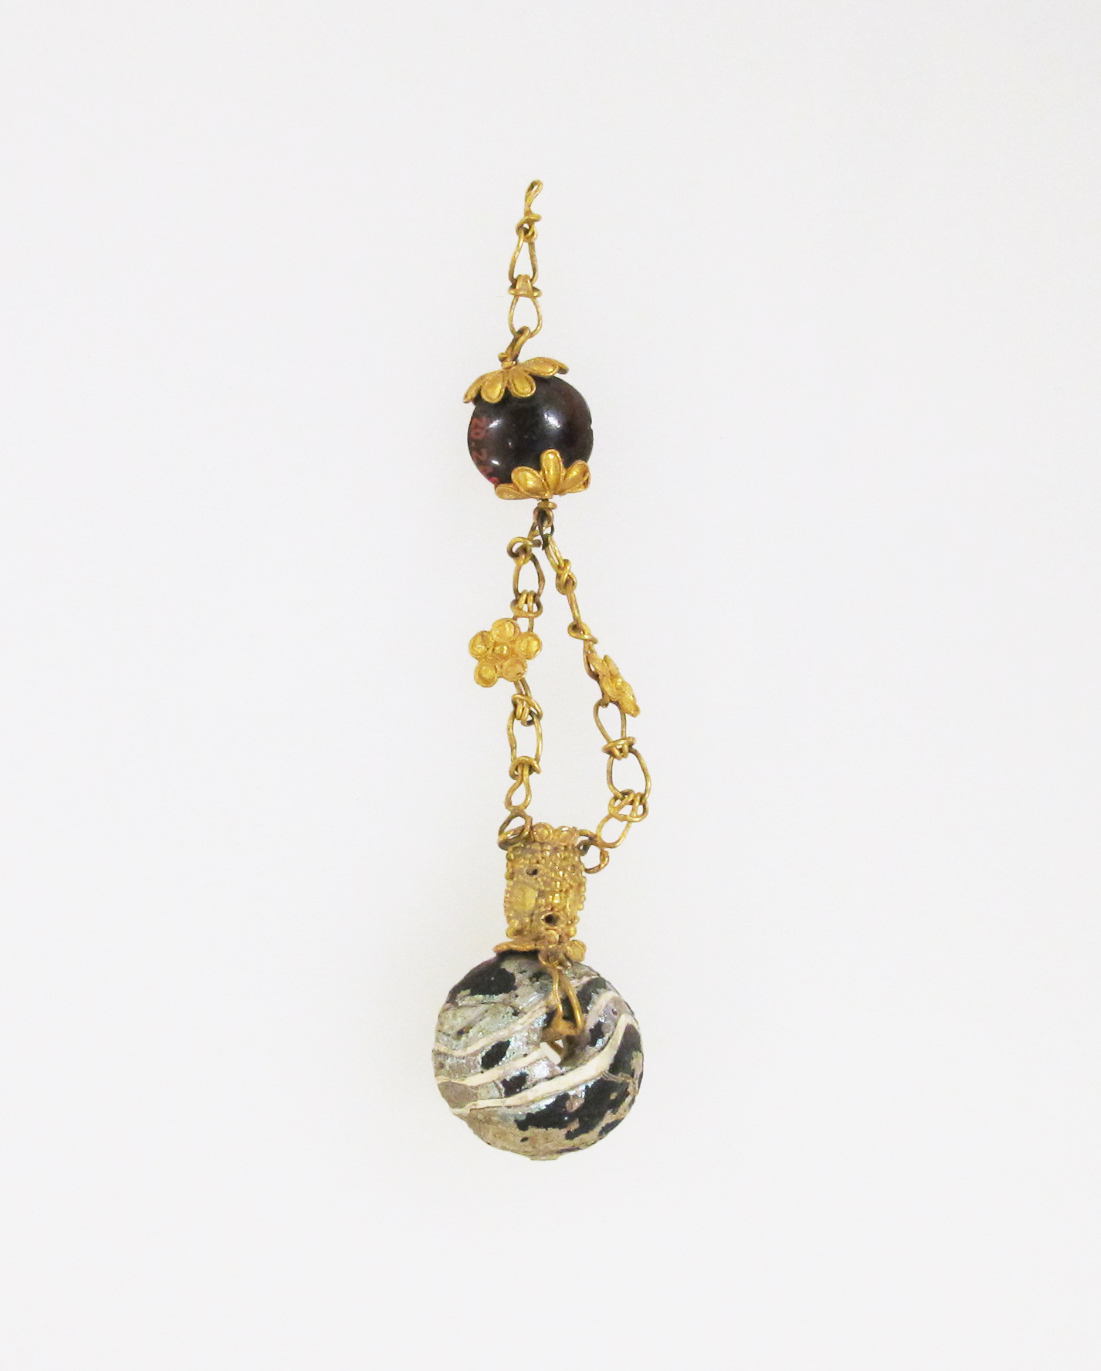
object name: pendant with garnet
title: Necklace with garnet pendant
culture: greek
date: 300-201 BCE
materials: gemstone, glass, gold